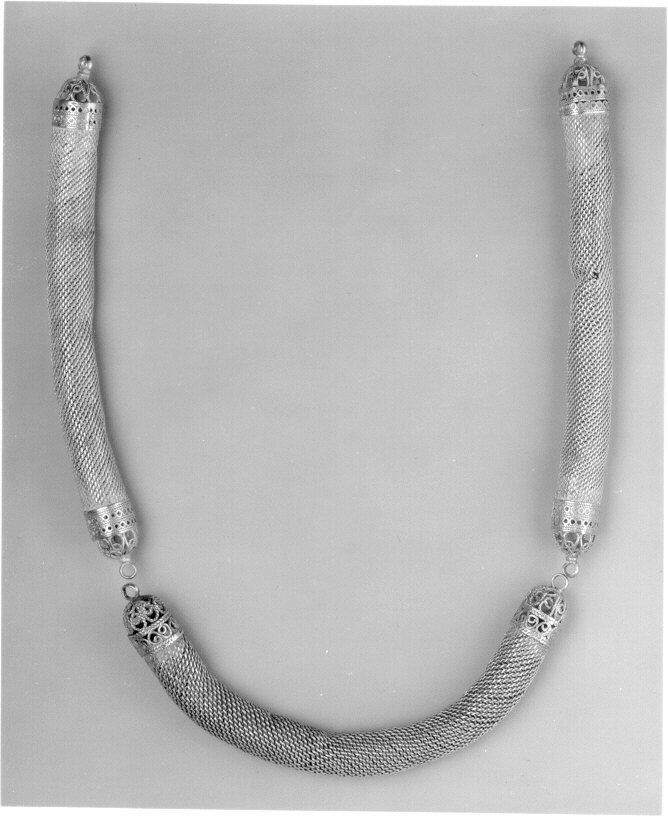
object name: necklace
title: Necklace Elements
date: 1001-1300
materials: gold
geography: iran